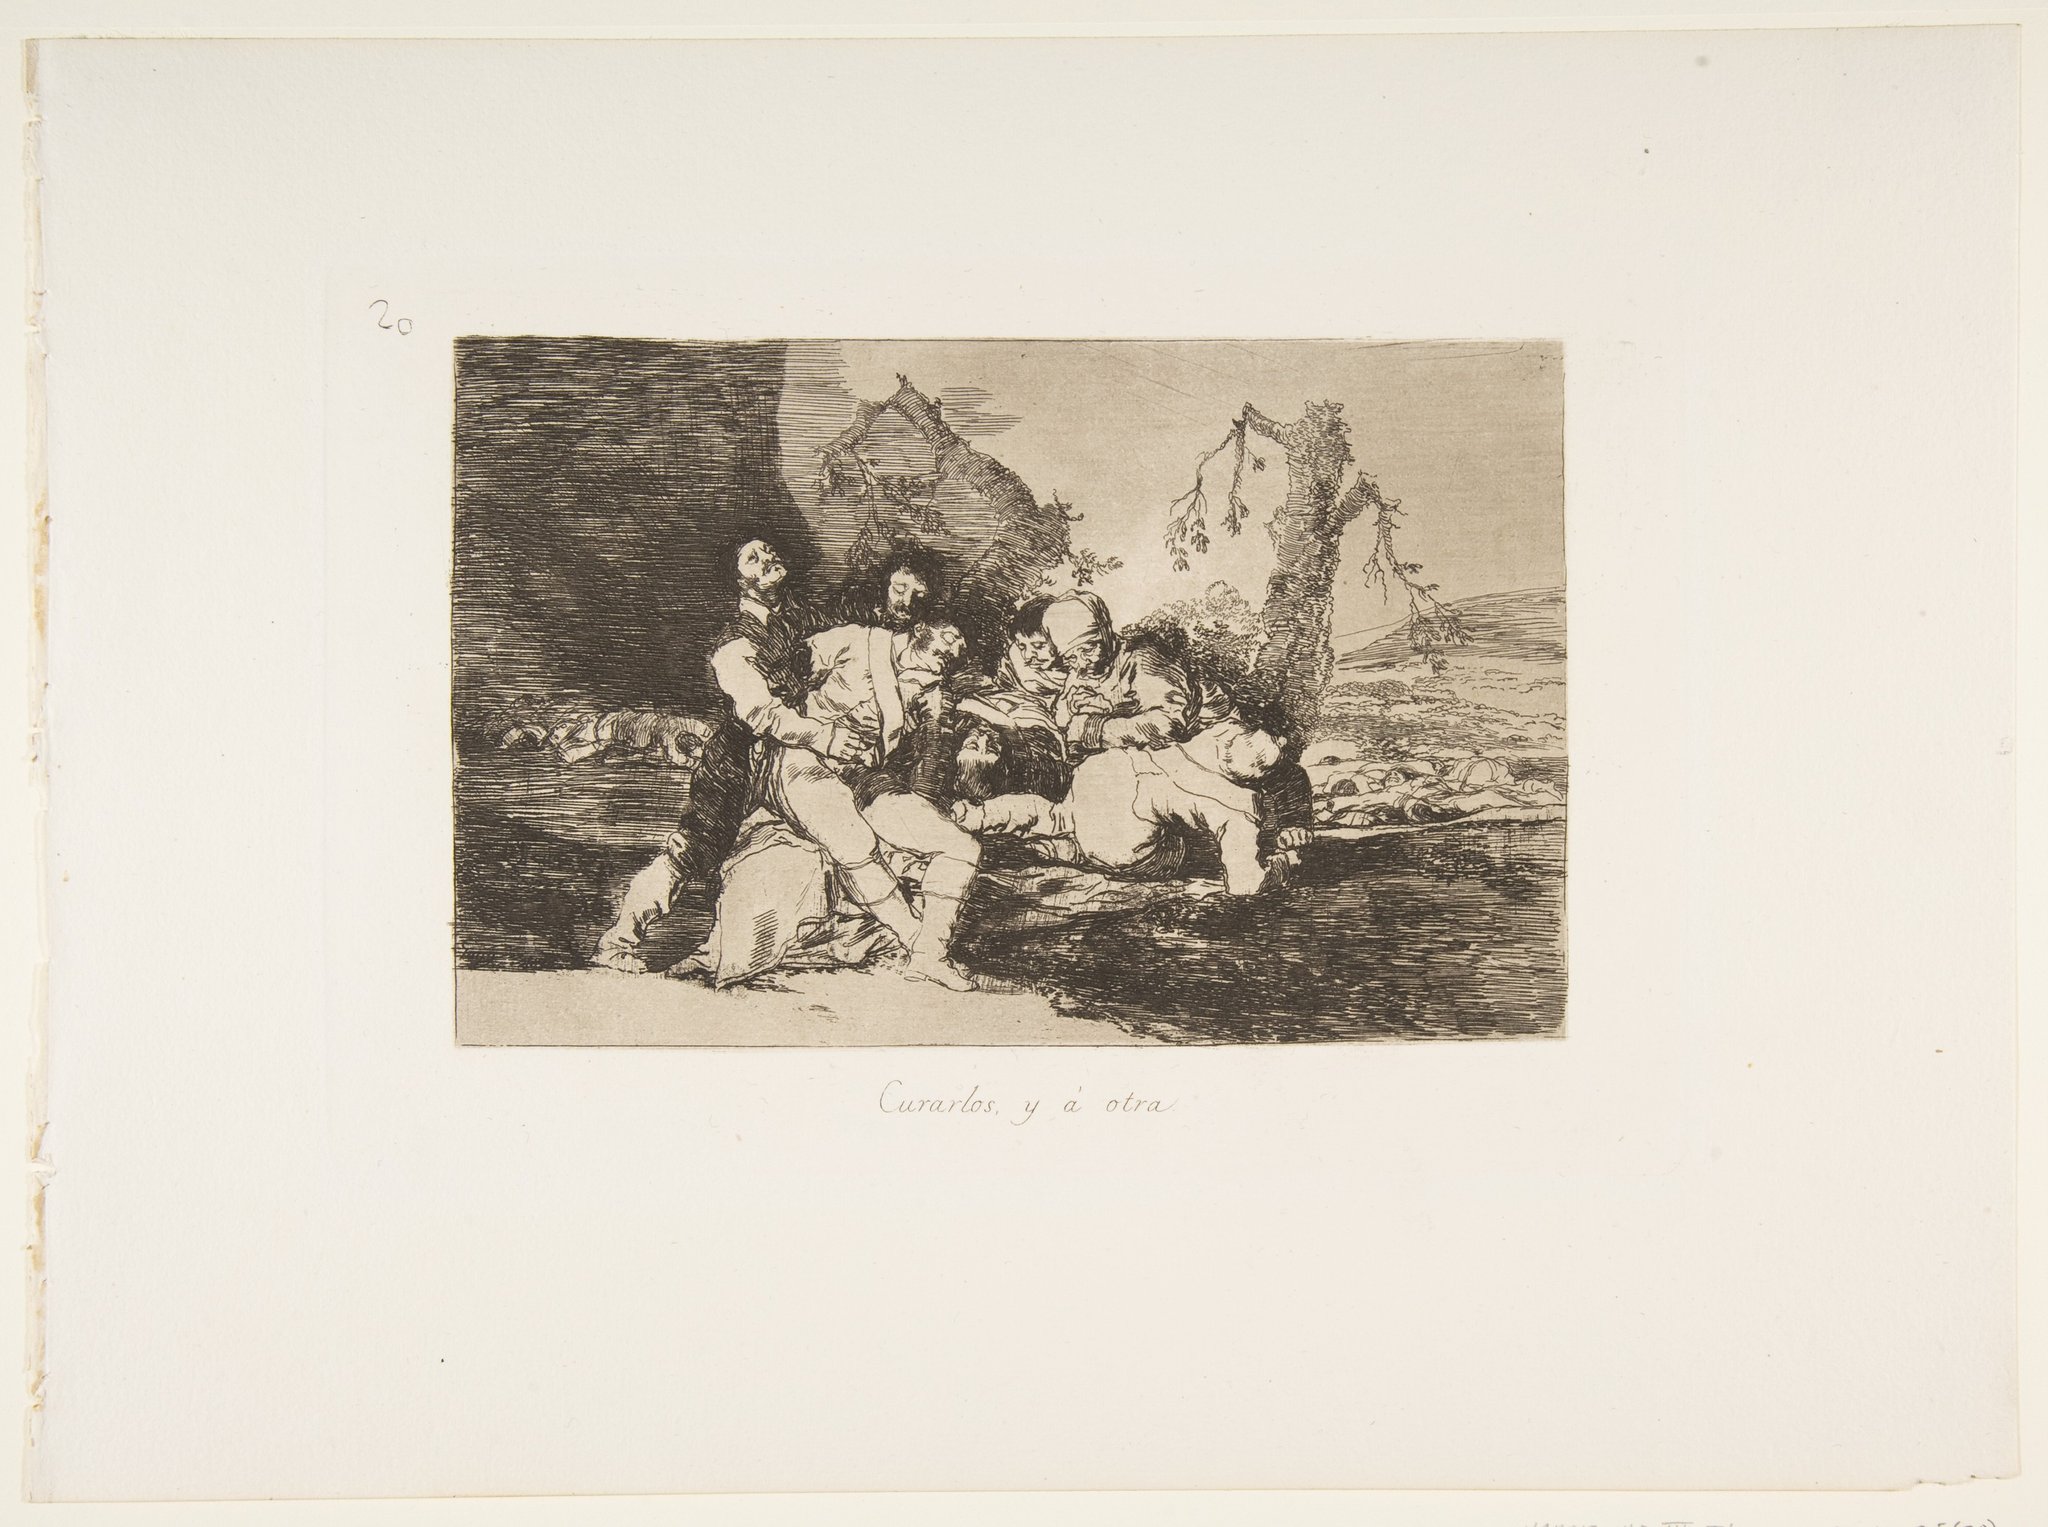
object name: print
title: Plate 20 from "The Disasters of War" (Los Desastres de la Guerra): 'Get them well, and on to the next' (Curarlos y á otra)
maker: goya (francisco de goya y lucientes)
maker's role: artist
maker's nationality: spanish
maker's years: 1746-1828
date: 1810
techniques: engraving, etching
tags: men